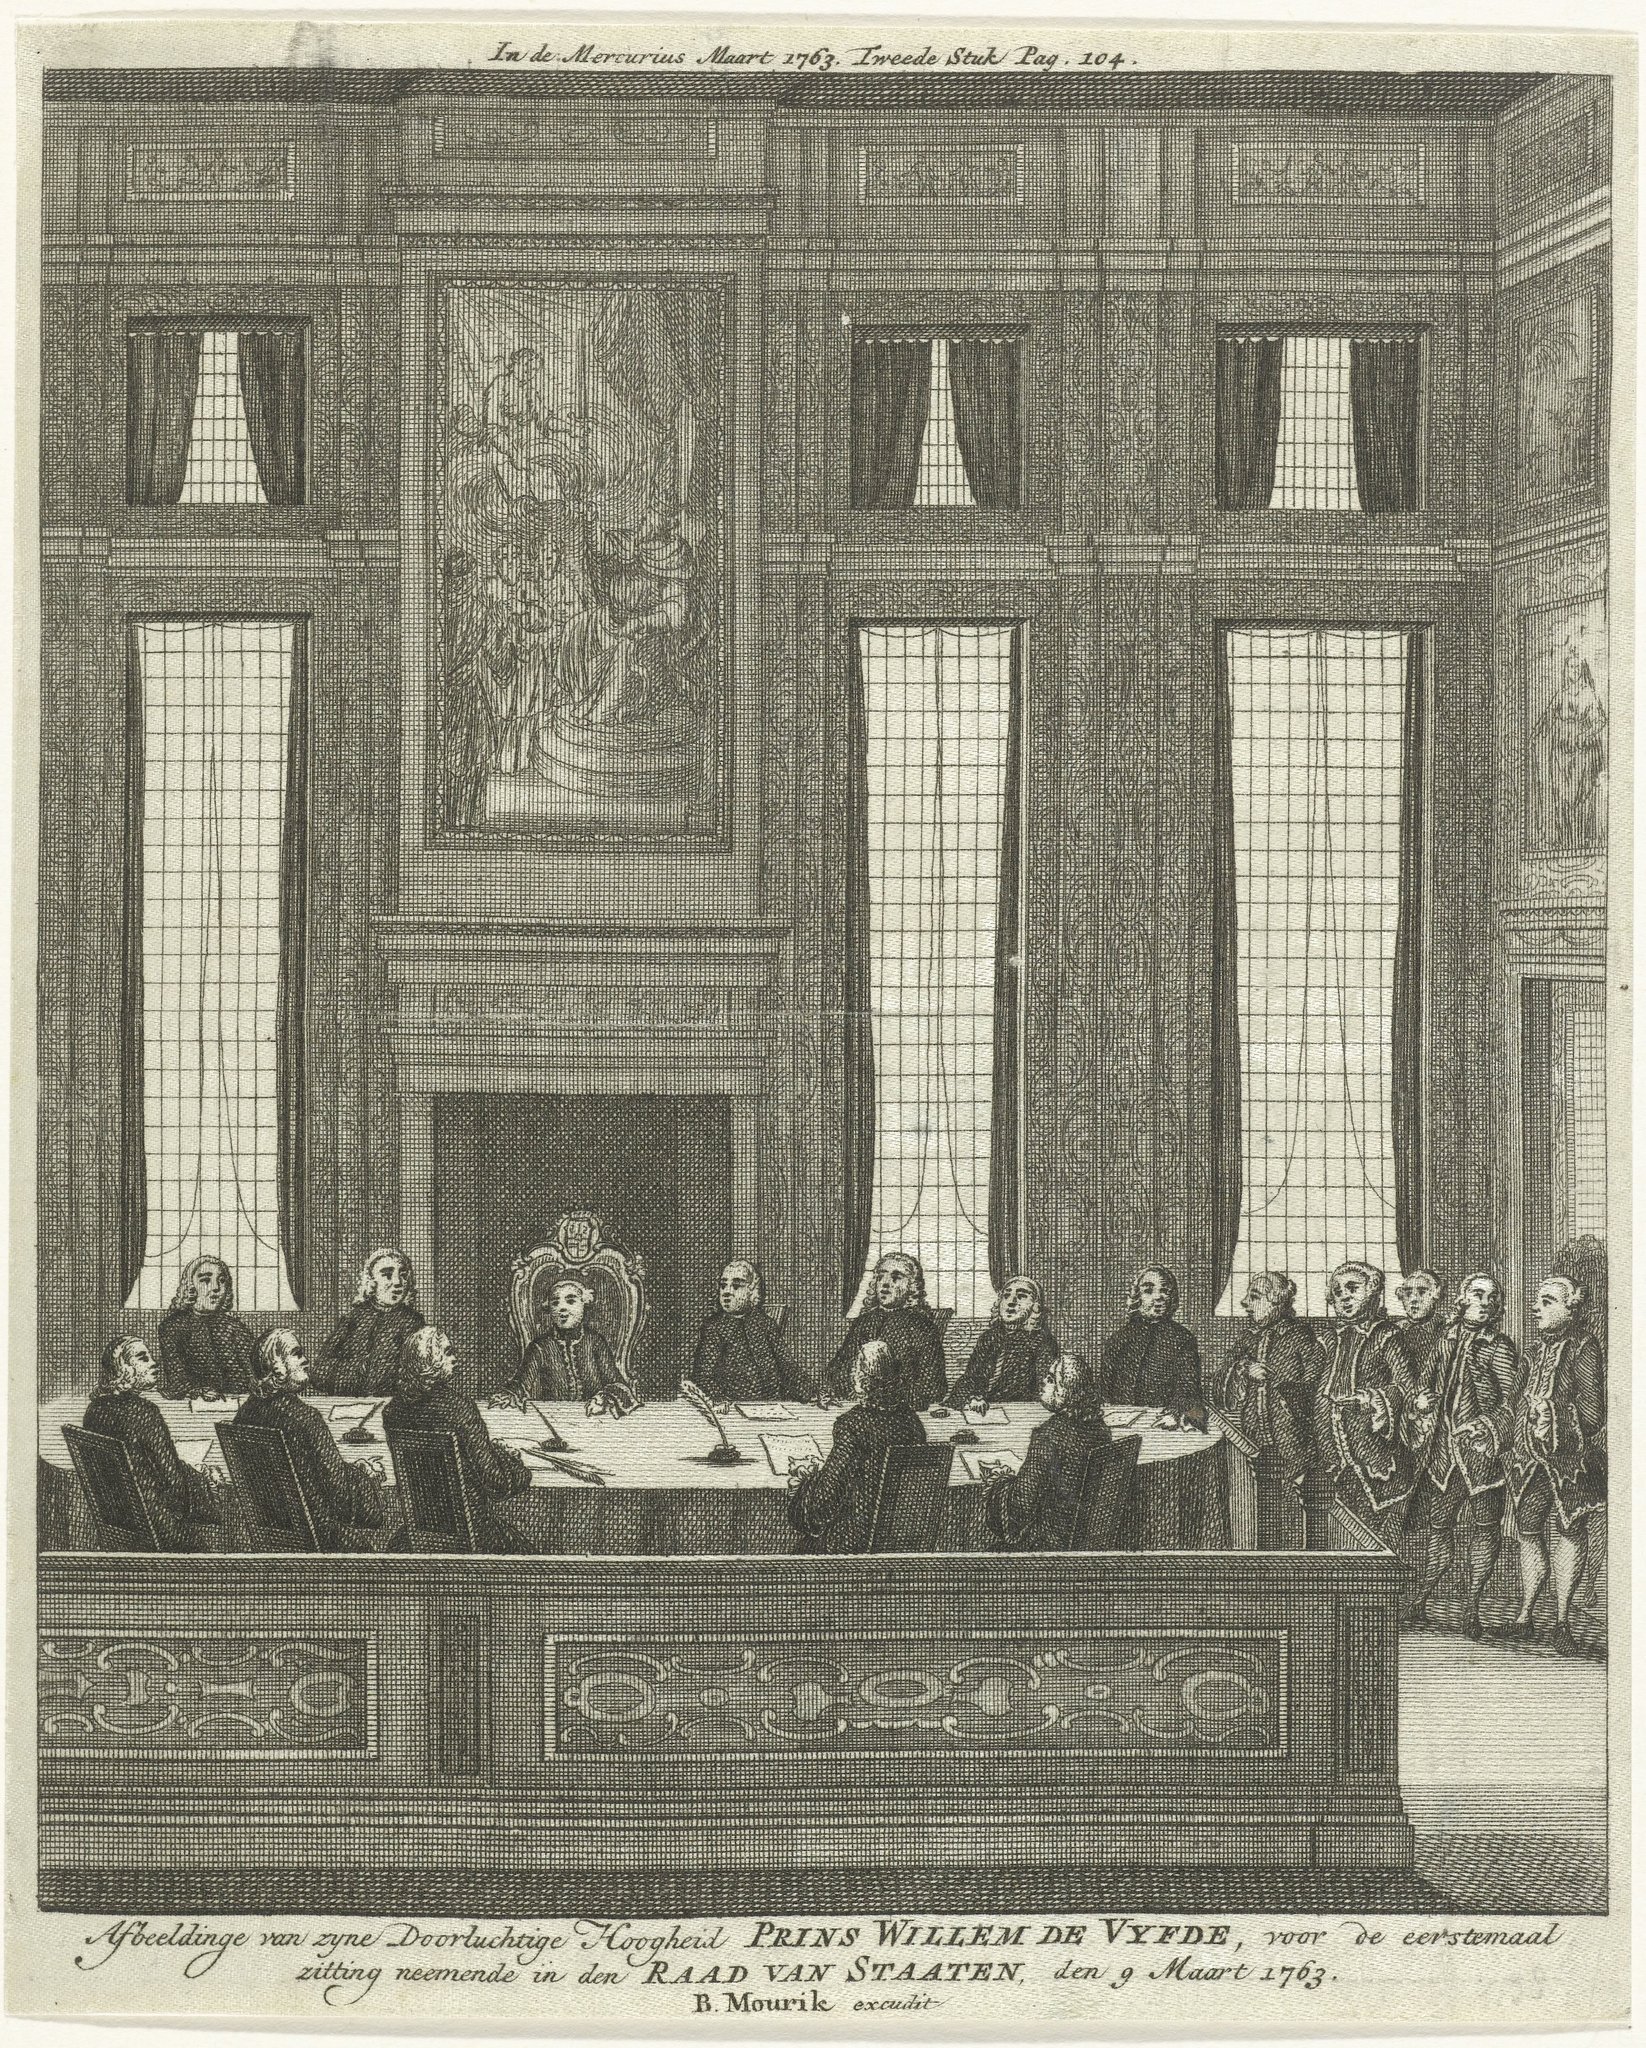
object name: print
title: Willem V neemt voor het eerst zitting in de Raad van State, 1763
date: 1763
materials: textile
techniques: etching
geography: northern netherlands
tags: the hague, william v (prince of orange), national government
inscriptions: collector's mark: Lugt 2228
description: Stadhouder Willem V, prins van Oranje, neemt op 9 maart 1763 voor het eerst zitting in de Raad van State.